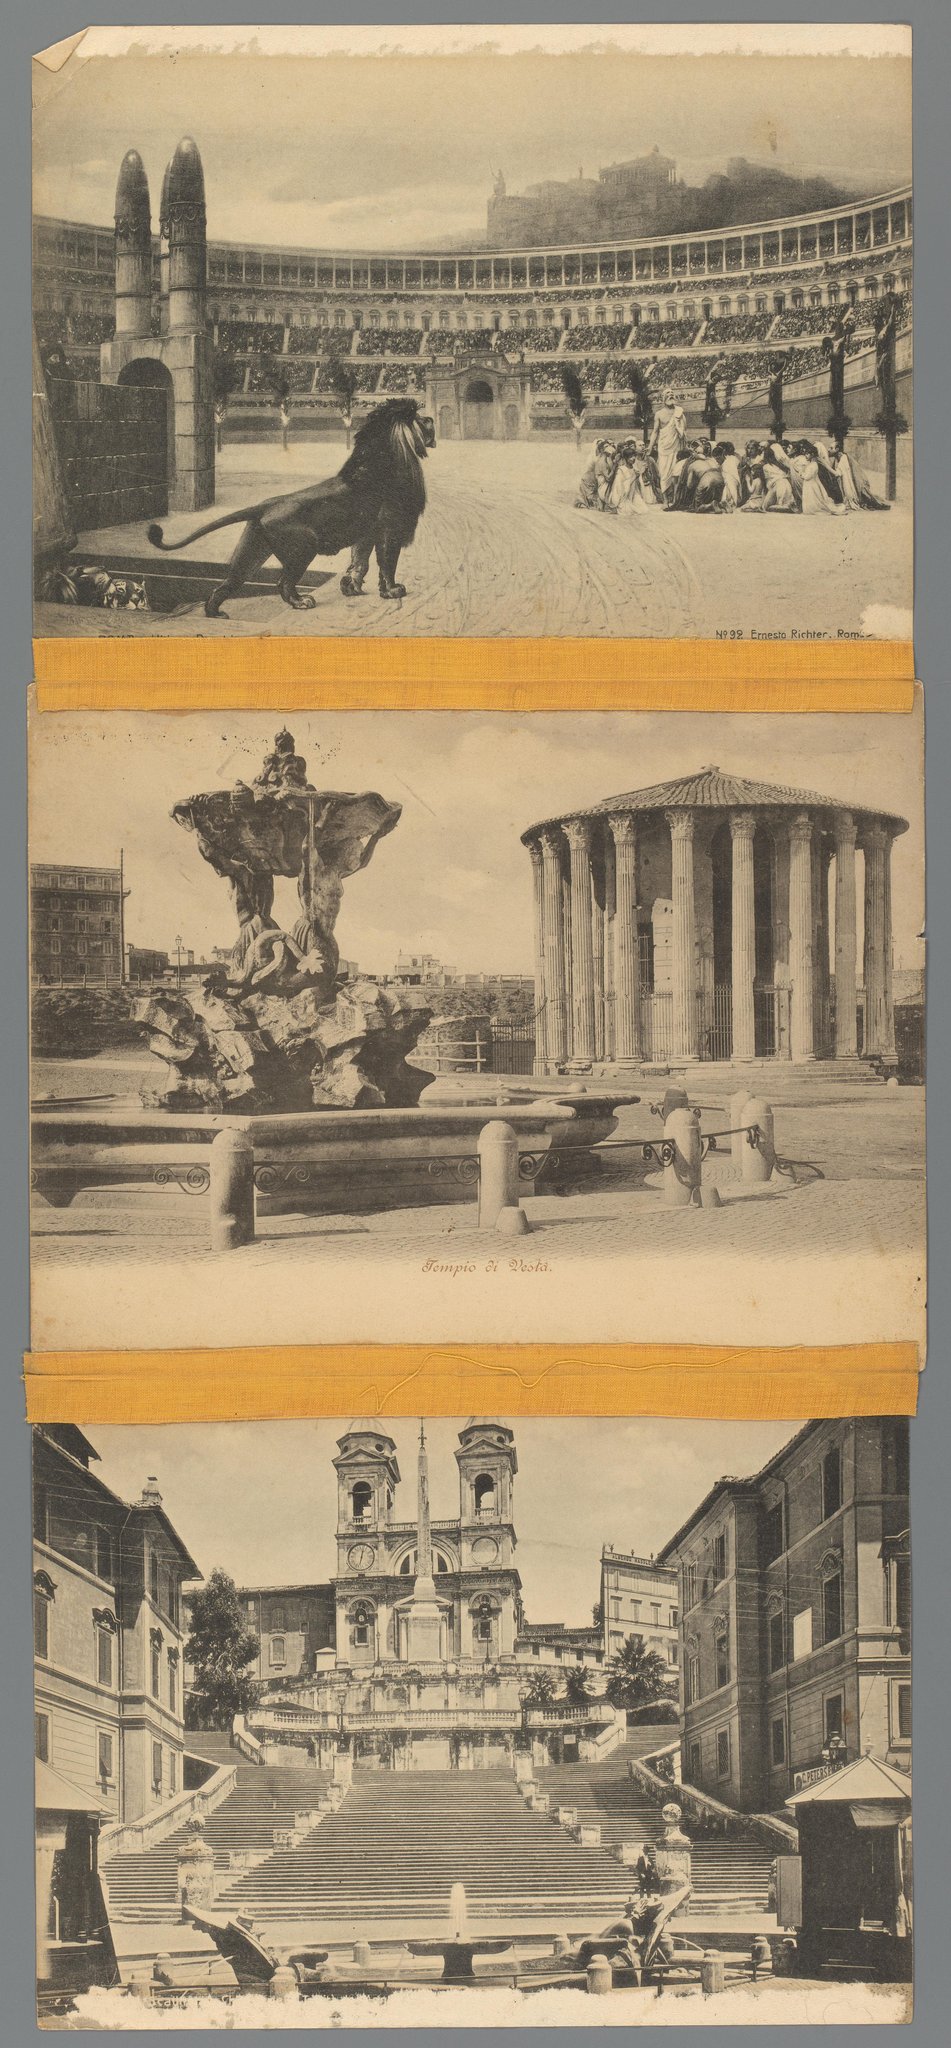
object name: stereograph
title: Paardentram op de Hogesluis met het Paleis voor Volksvlijt, Amsterdam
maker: Anonymous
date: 1896-1918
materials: cardboard, paper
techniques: albumen print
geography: amsterdam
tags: tramway, tram, edifice, e.g.: public building, department store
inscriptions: inscription: ‘Amsterdam/ Hooge Sluis/ 36’